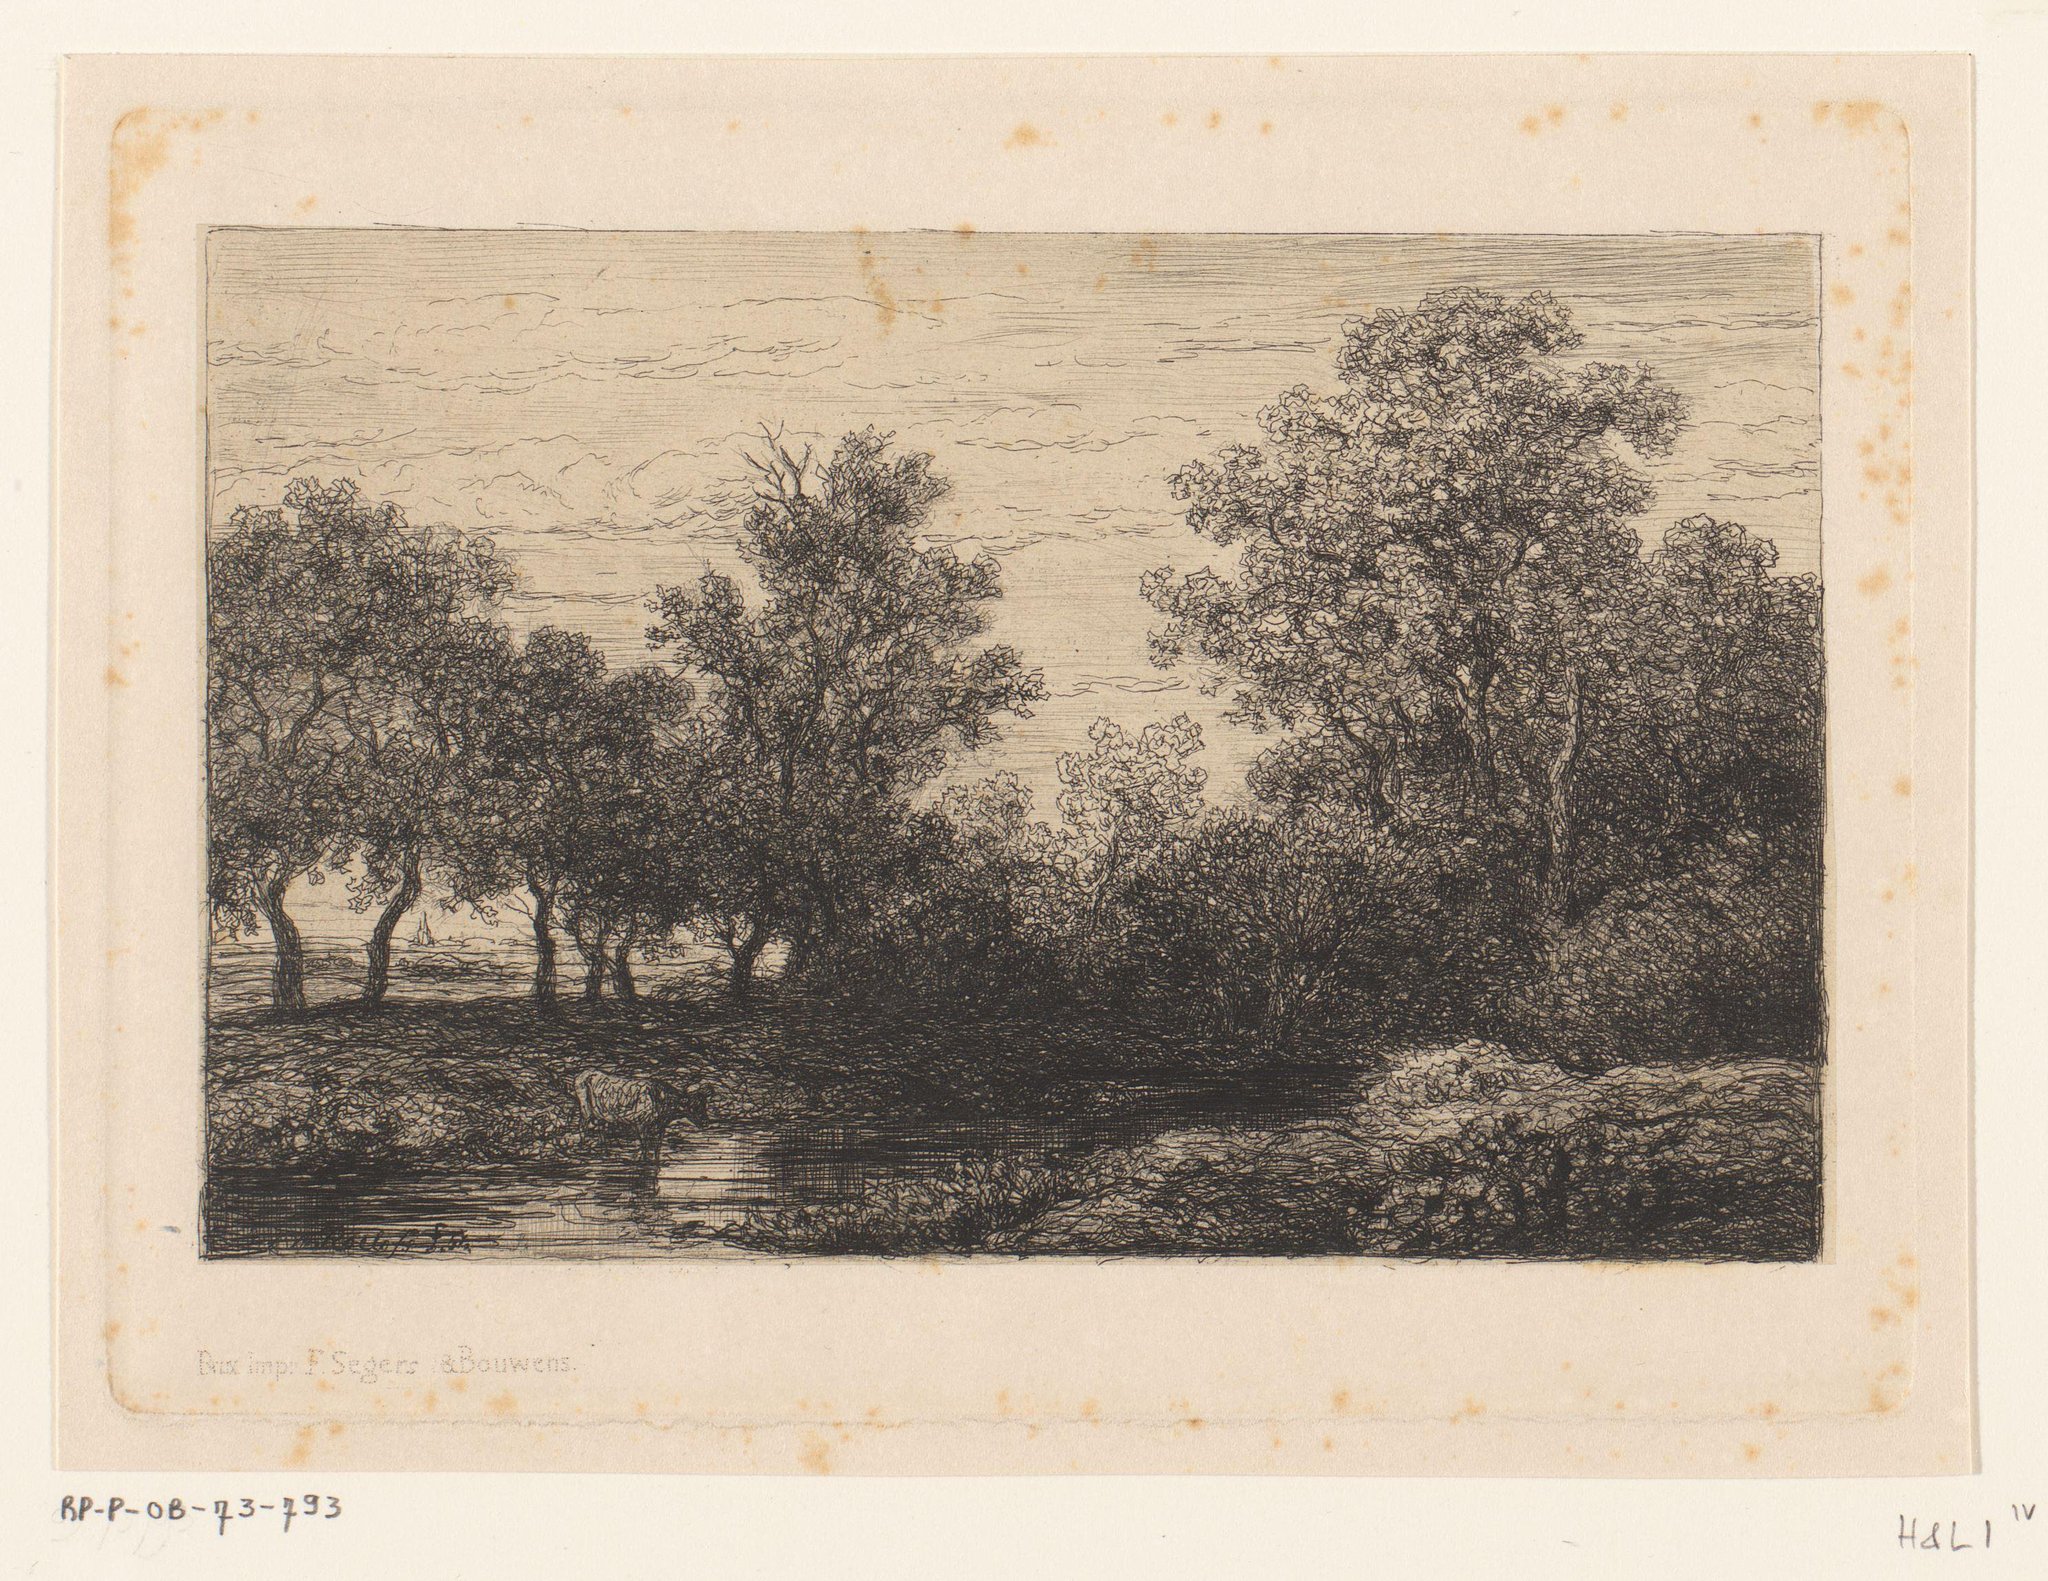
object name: print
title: Beek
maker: willem roelofs (i)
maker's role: draughtsman, painter, print maker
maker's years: 1822-1897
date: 1851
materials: paper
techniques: drypoint, etching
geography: brussels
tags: cow, church (exterior), brook, groups of trees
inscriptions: collector's mark: Lugt 12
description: Een boomrijk landschap met links op de voorgrond een koe bij een beek. Op de achtergrond de contouren van een kerk.